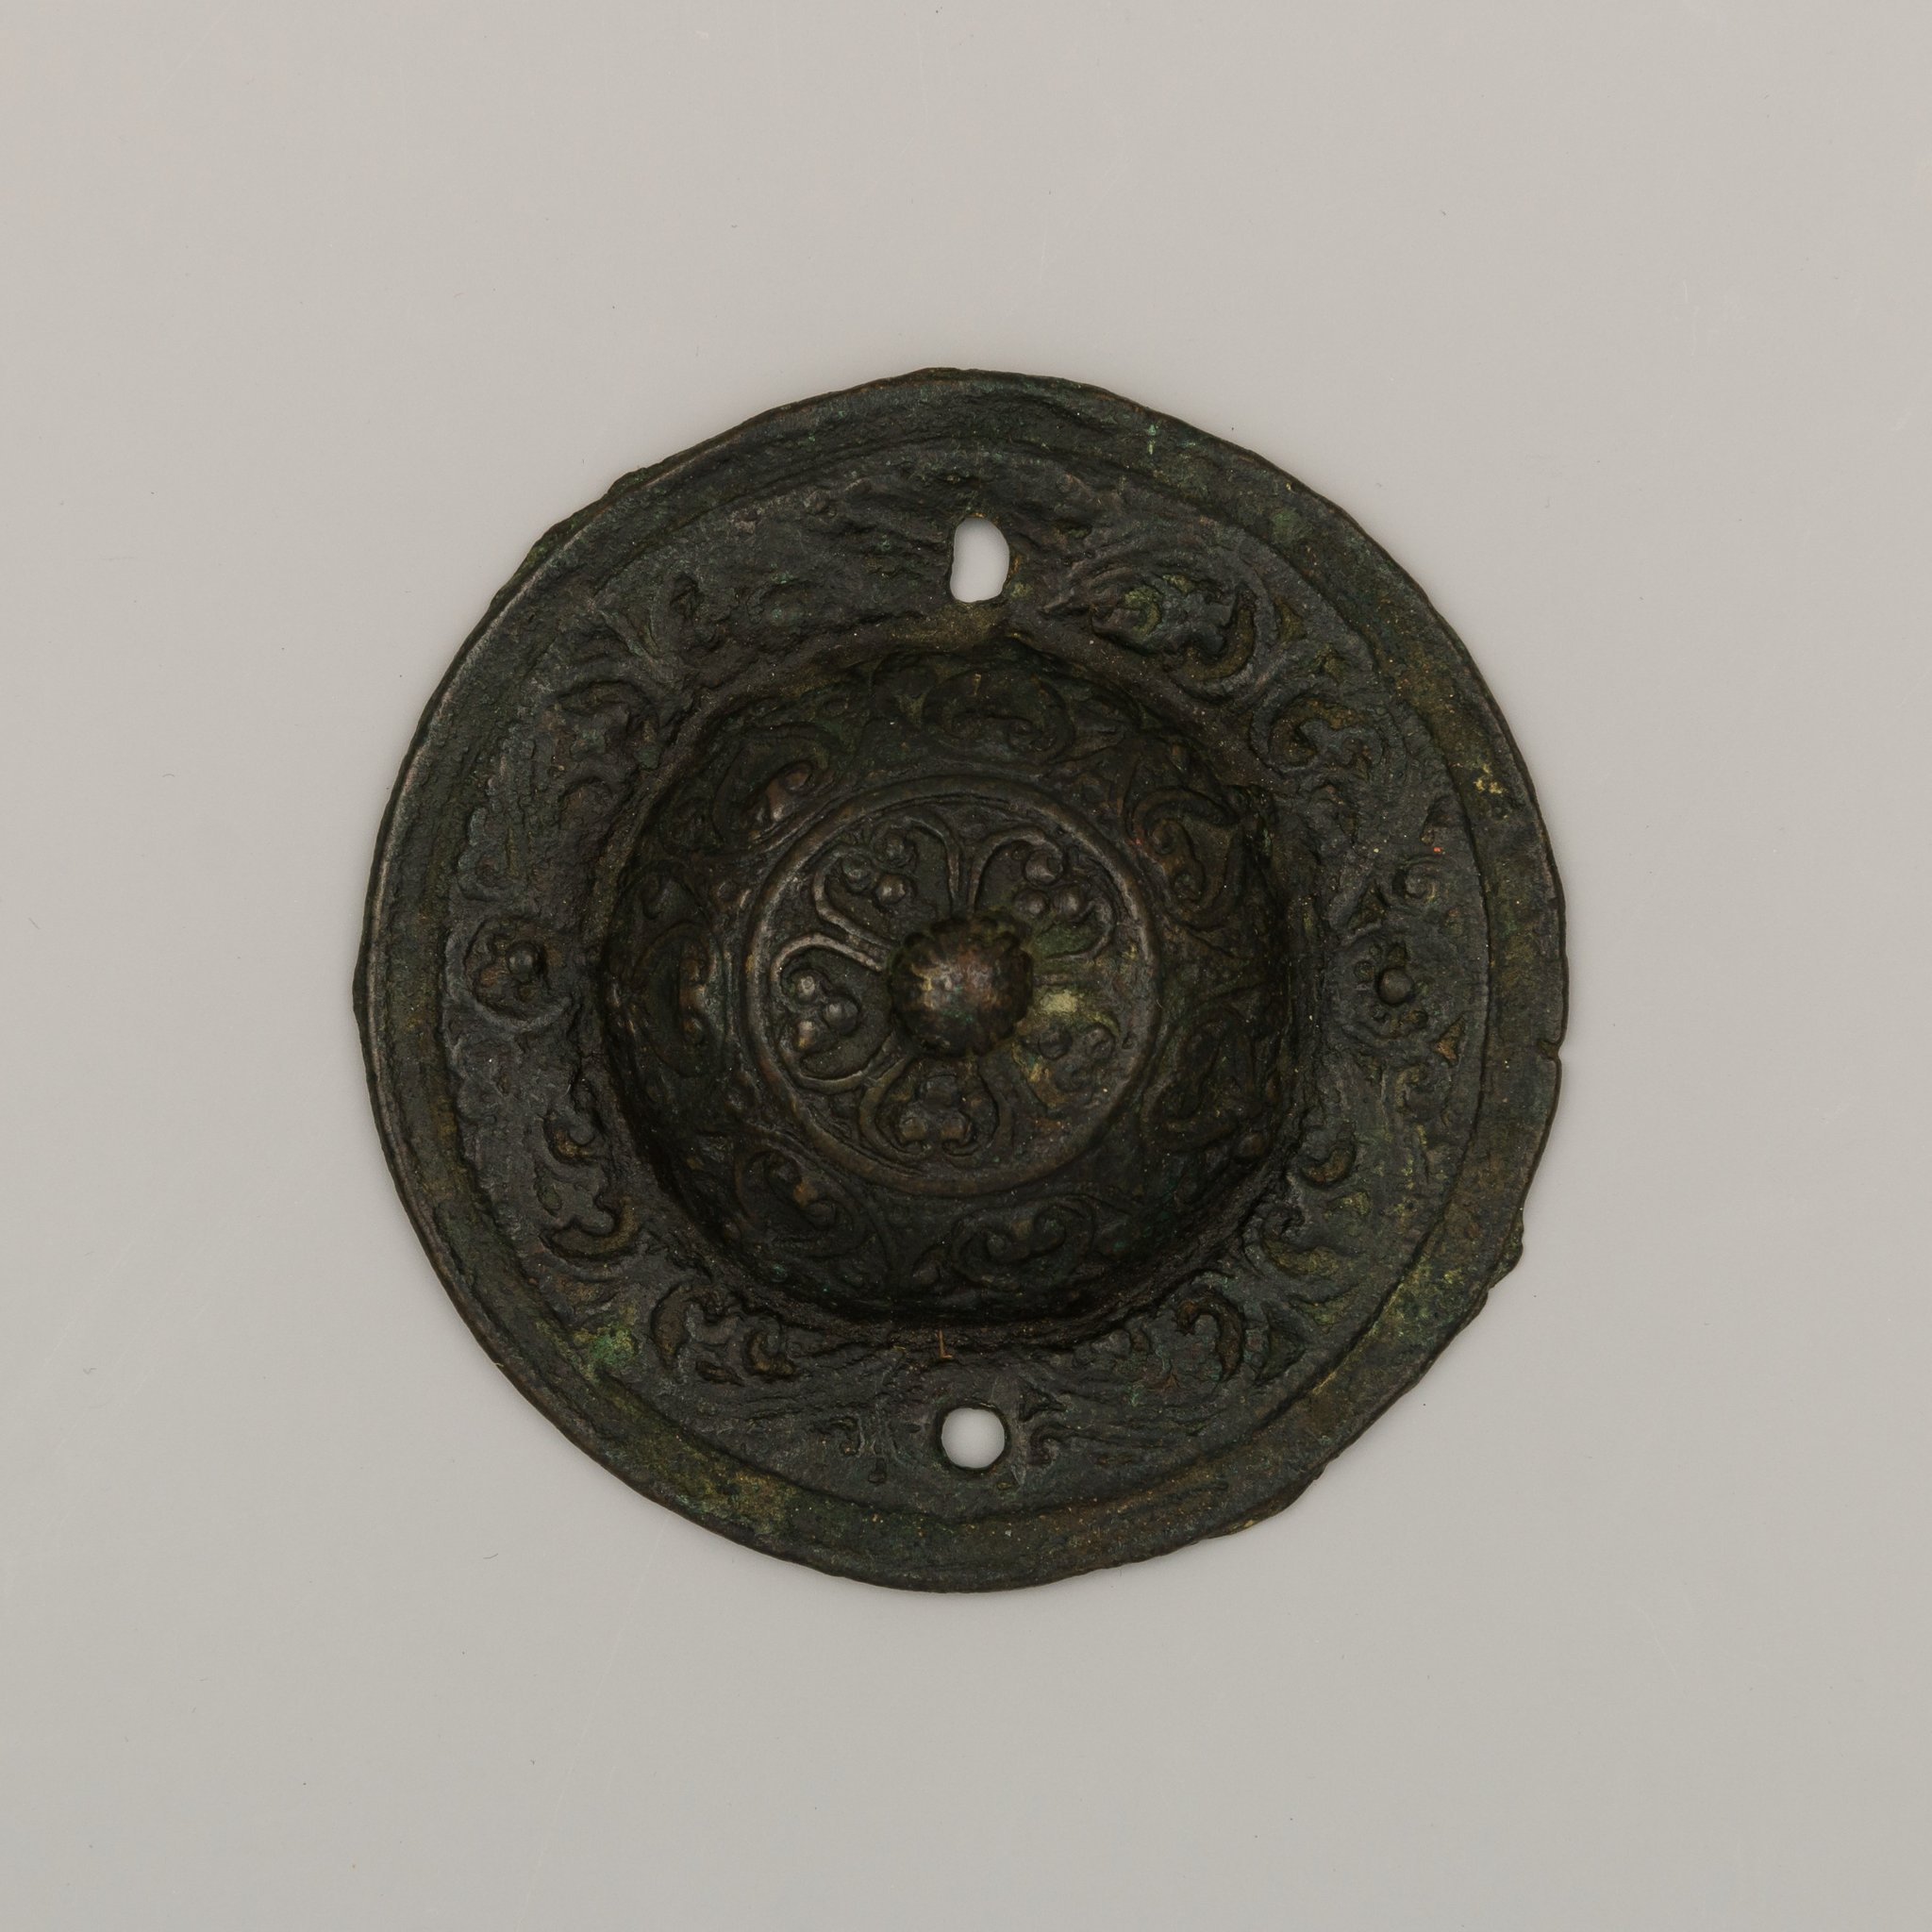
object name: bit bos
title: Bit Boss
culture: italian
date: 1567-1700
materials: copper alloy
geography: italy